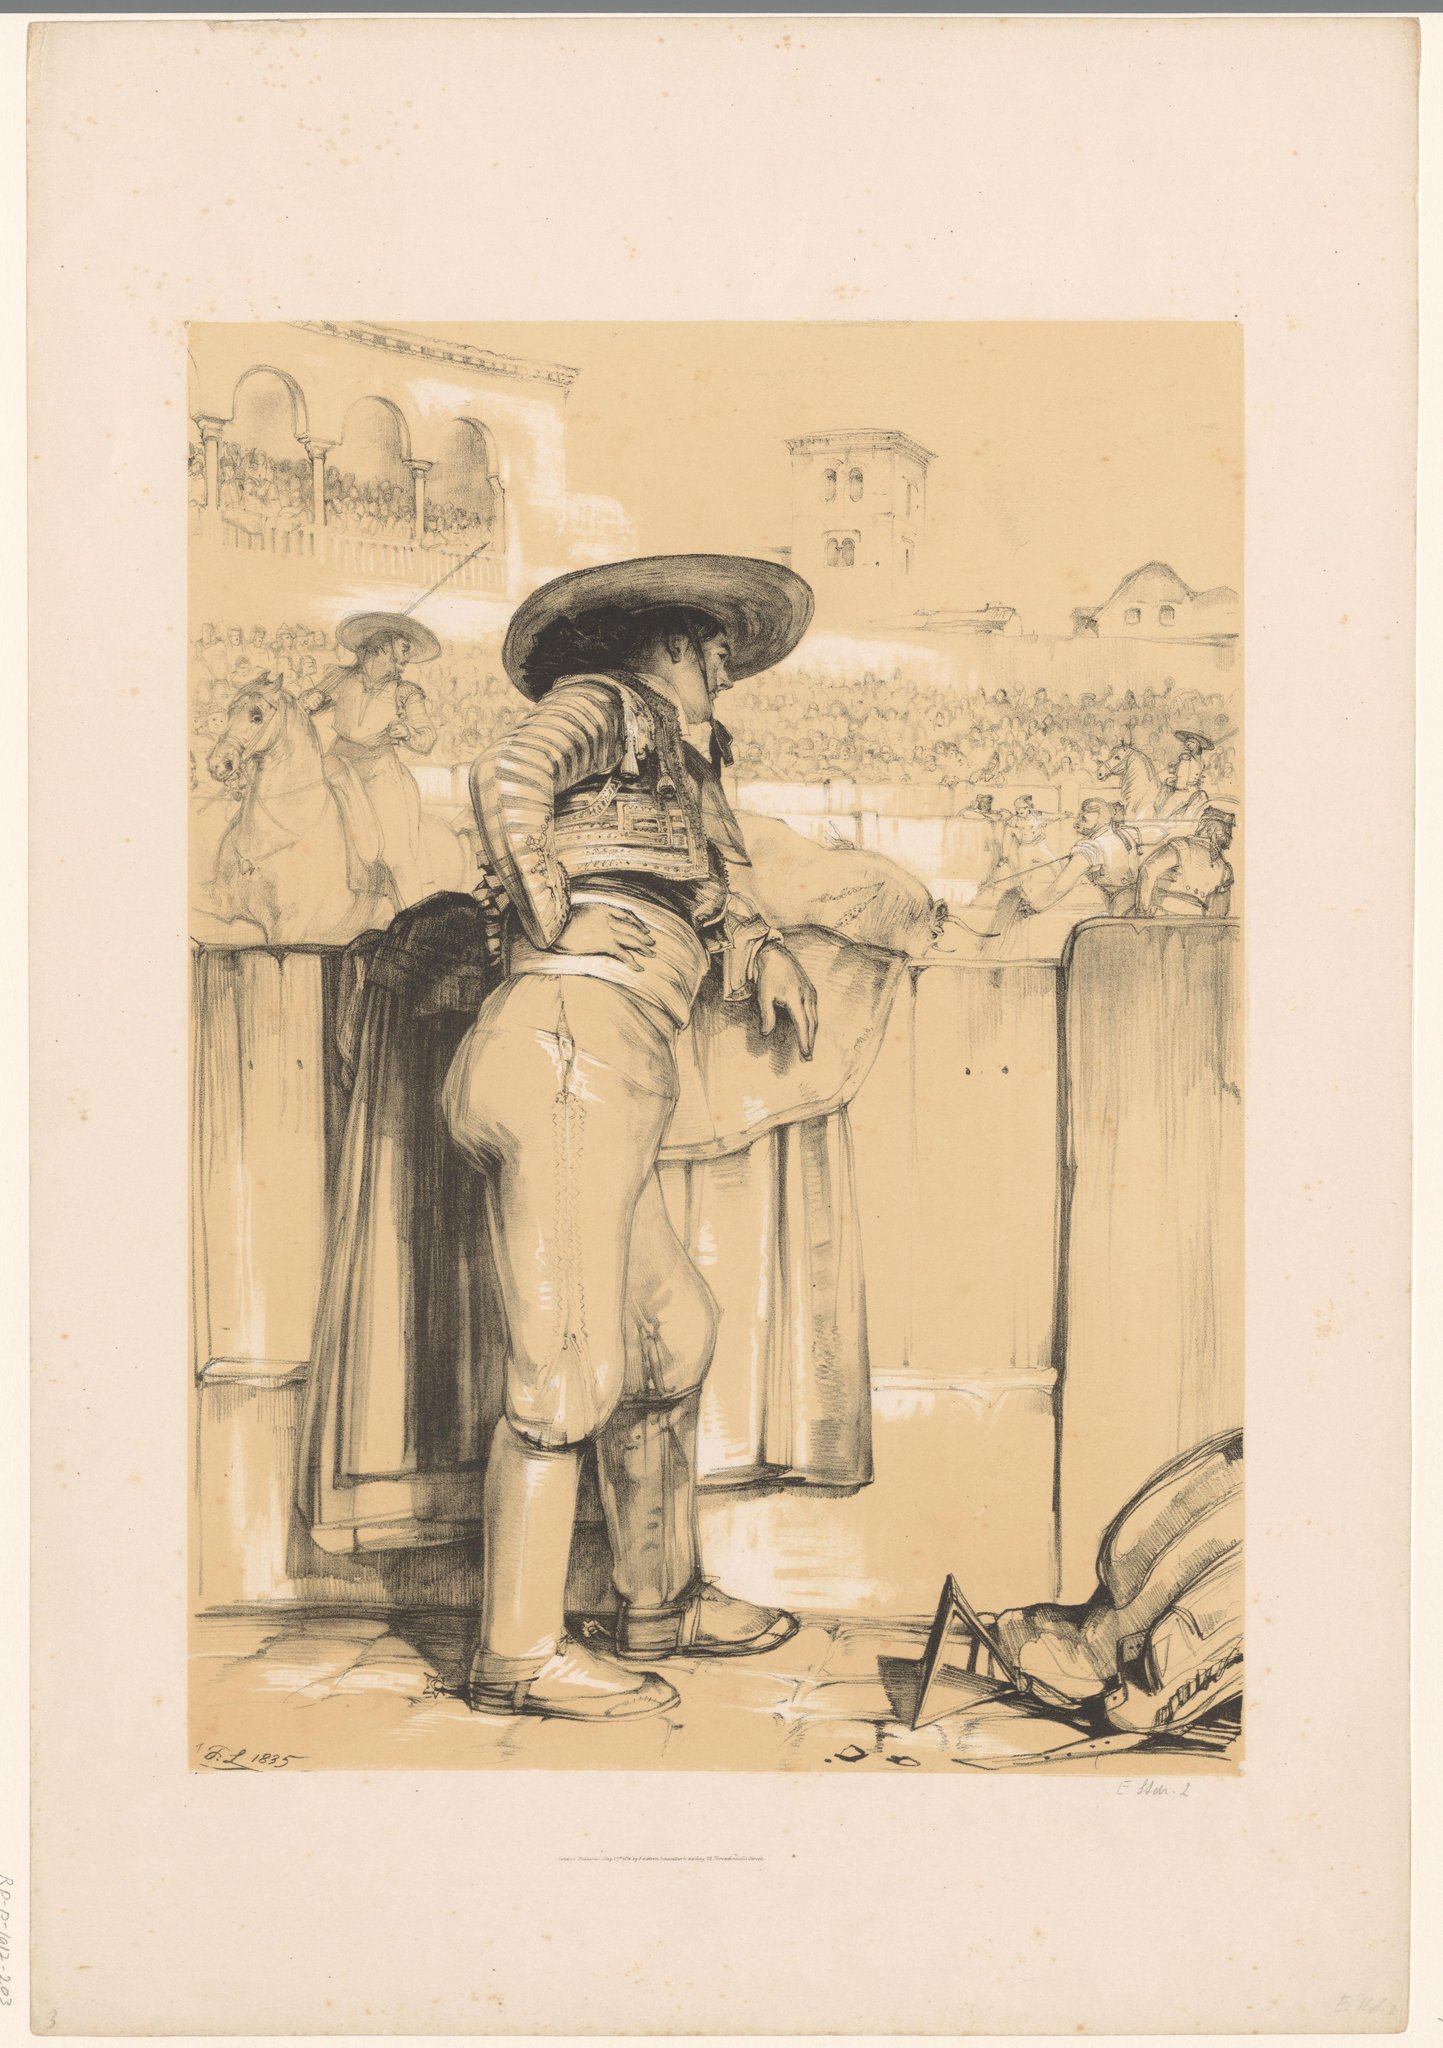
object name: print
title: Lewis's sketches of Spain & Spanish character, made during his tour in that country, in the years 1833-4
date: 1836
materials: paper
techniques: tone lithography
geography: london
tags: bullfight, bull-fighter, toreador, spain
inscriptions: collector's mark: Lugt 2228